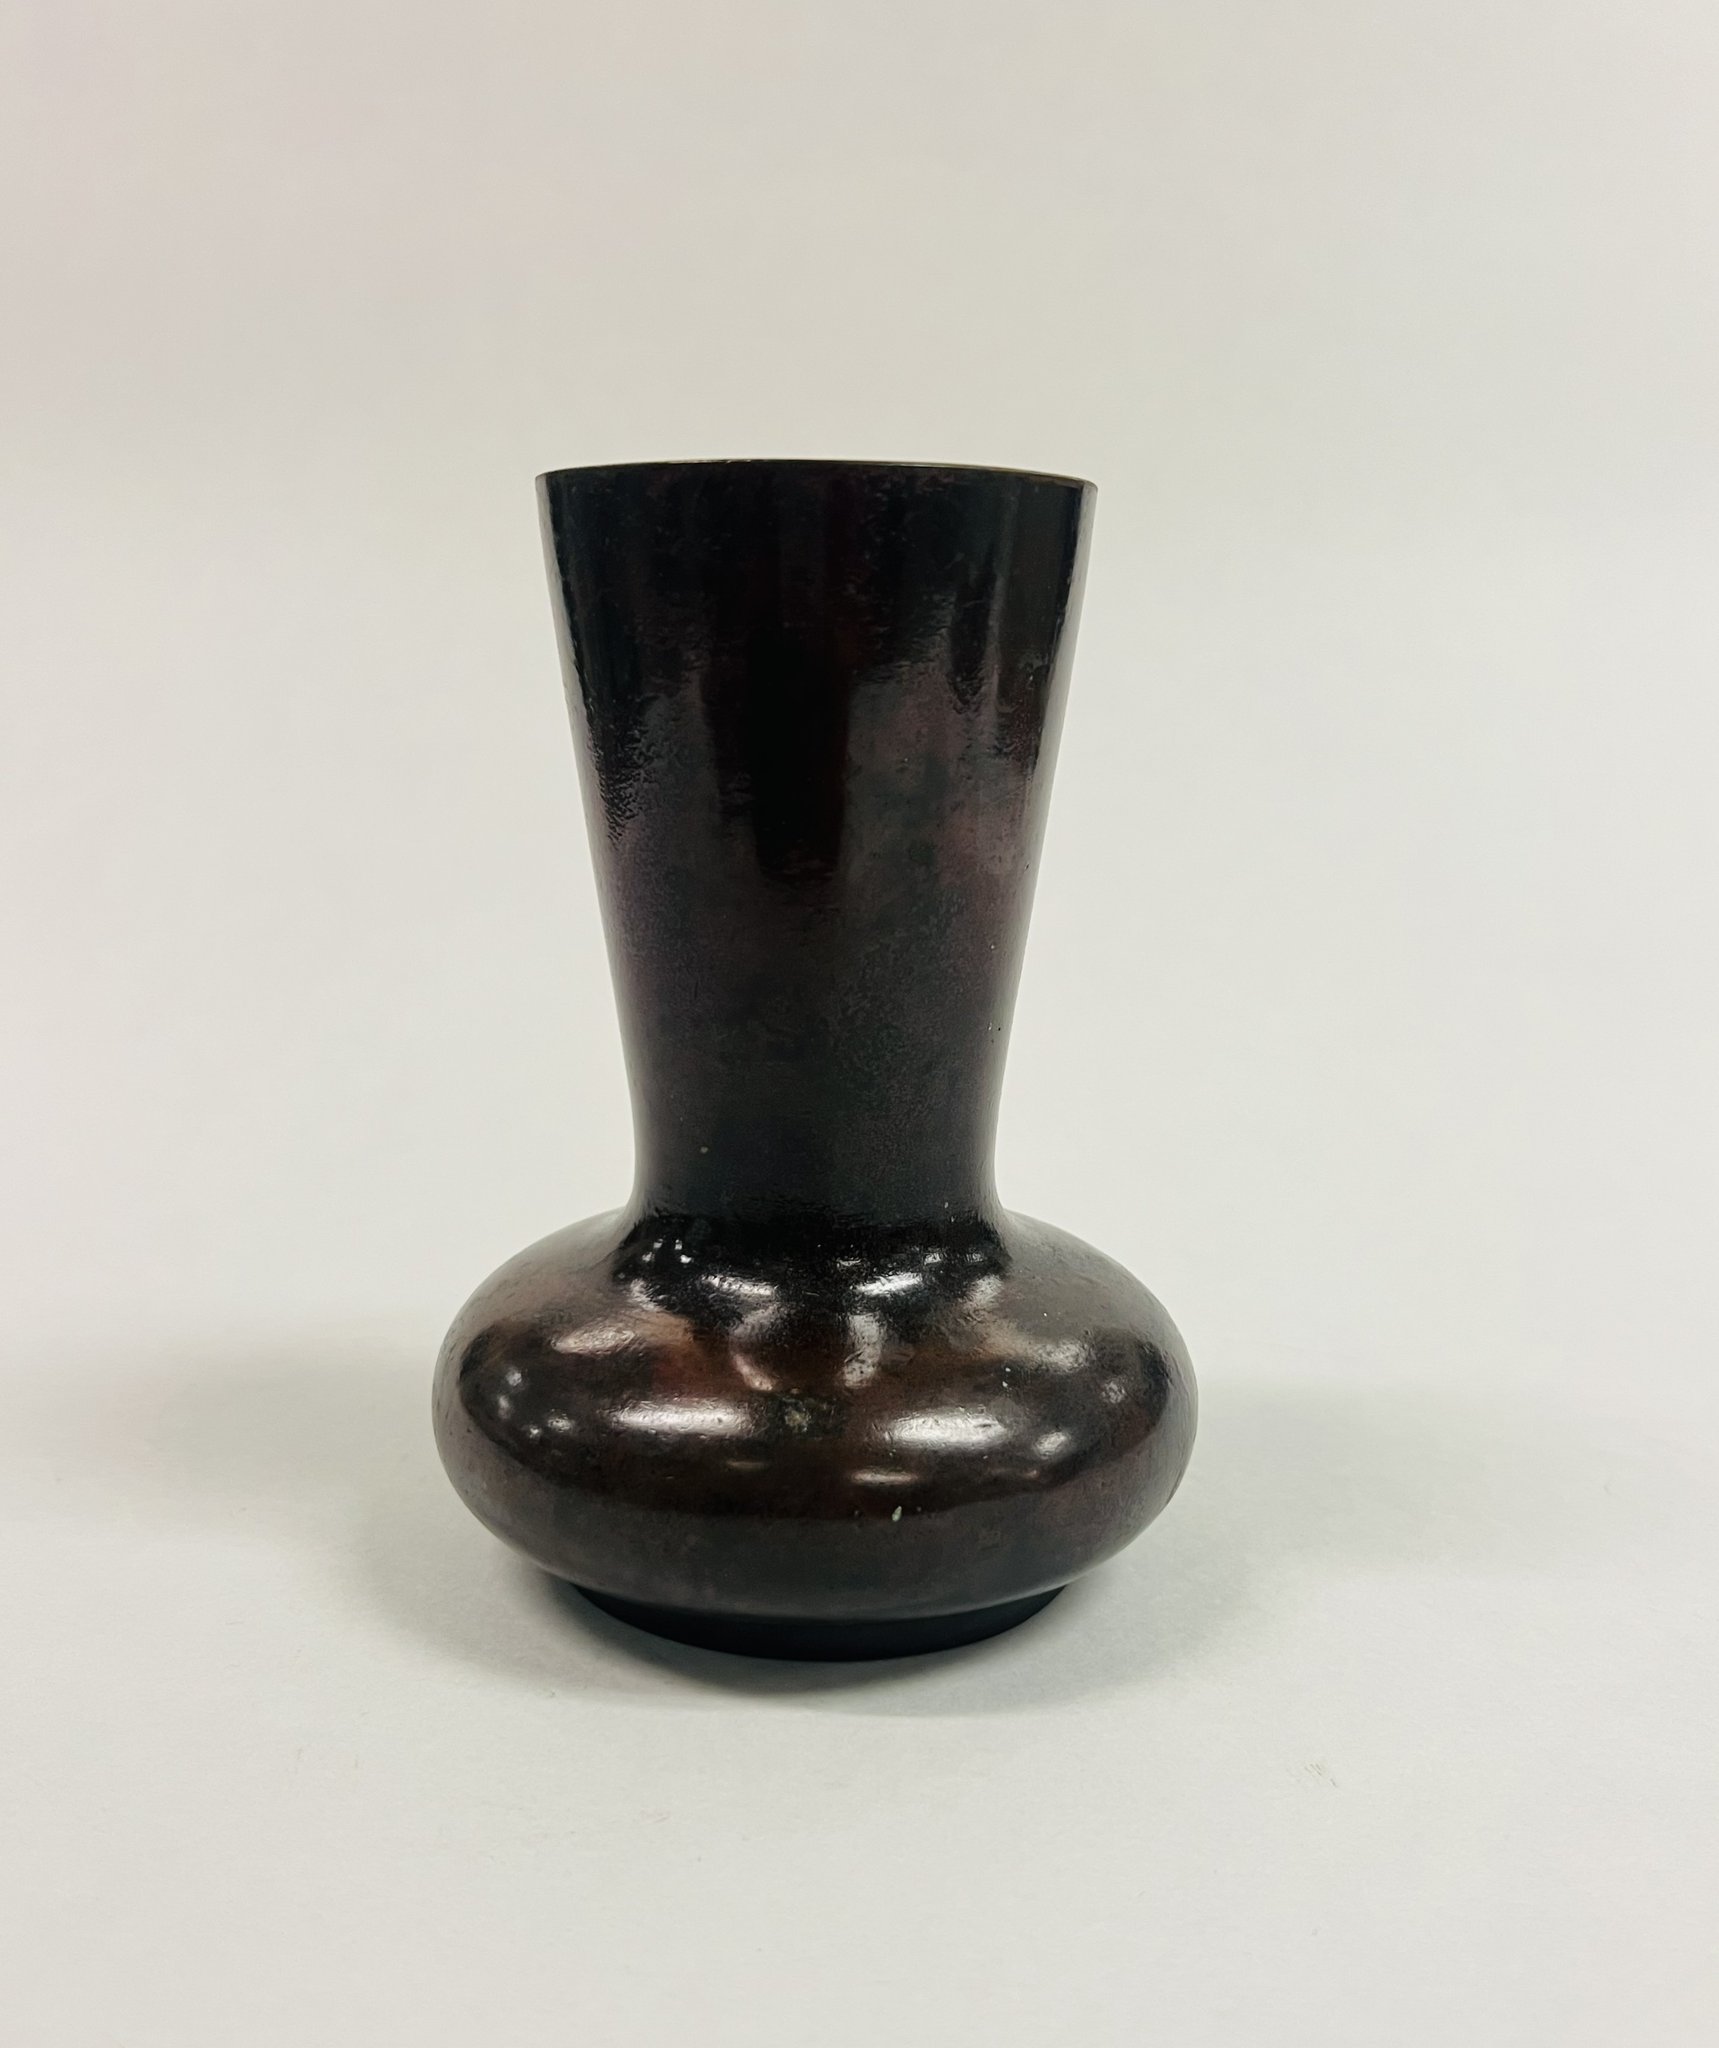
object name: vase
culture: japanese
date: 1734-1900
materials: bronze